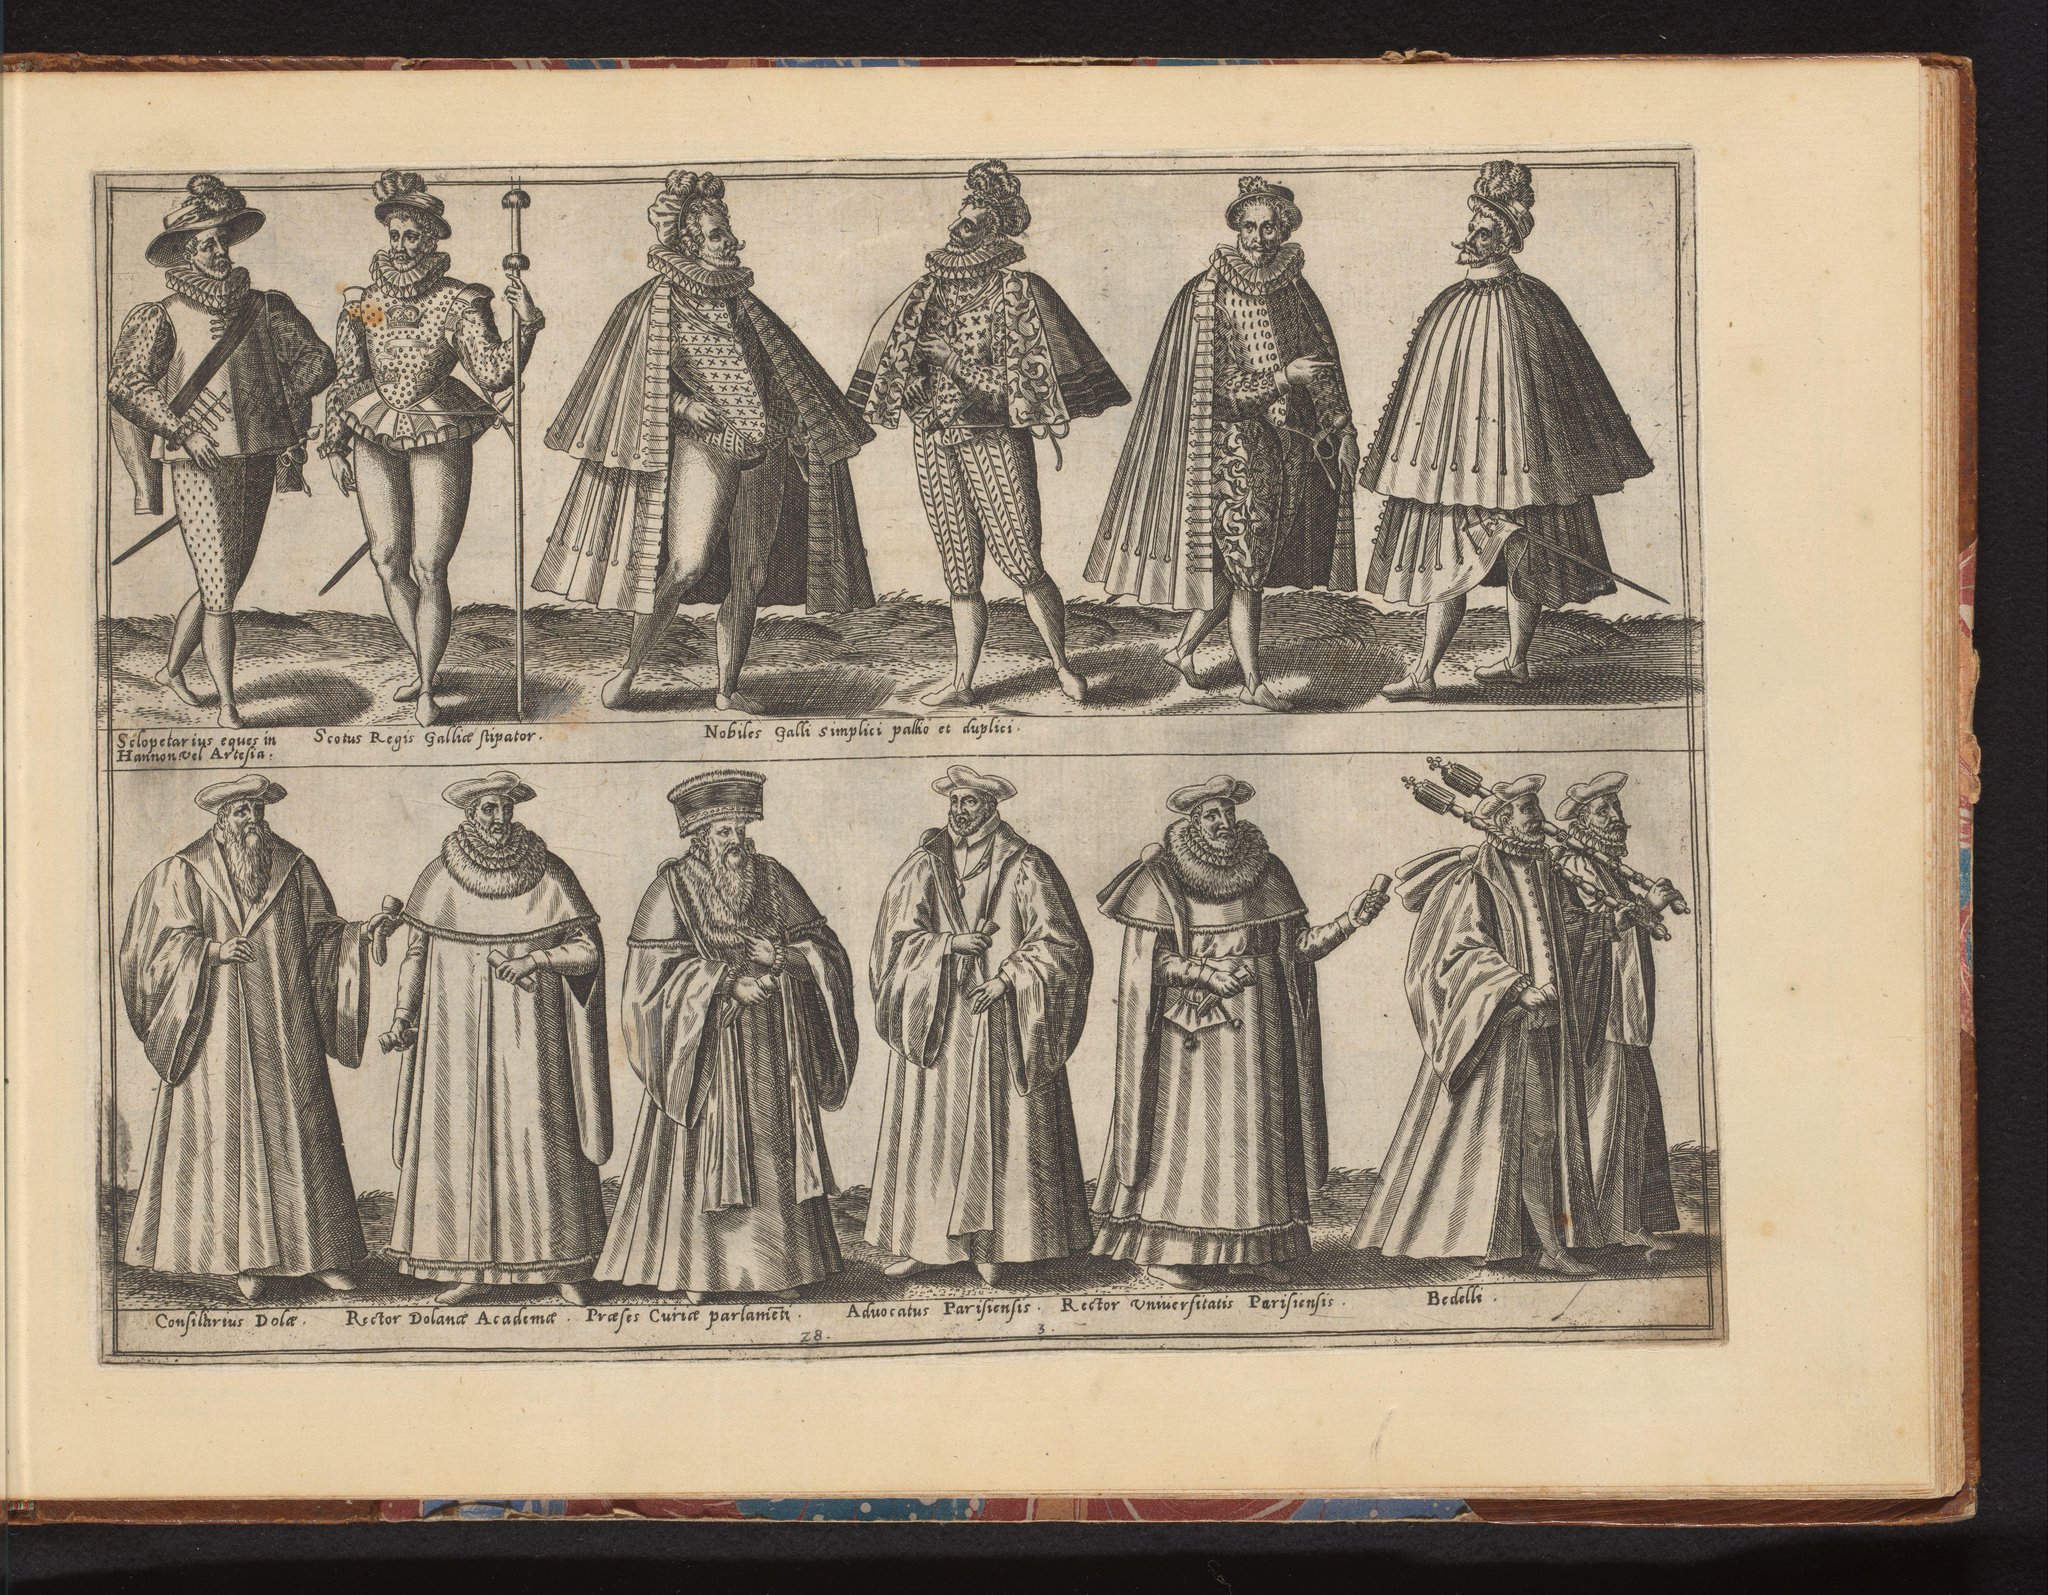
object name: album leaf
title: Dertien mannen uit verschillende standen, gekleed volgens de Franse mode van ca. 1580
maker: abraham de bruyn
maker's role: print maker, publisher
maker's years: 1540-1587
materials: paper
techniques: engraving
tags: europeans (with name) (+ costume), europeans (frenchmen) (+ men), bourgeoisie, middle class, citizens, burghers, clothes, costume (+ men's clothes), nobility and patriciate; chivalry, knighthood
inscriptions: number: ‘28’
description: Twee rijen boven elkaar. Prent uit het boek 'Omnium pene Europae, Asiae, Aphricae atque Americae gentium habitus...', 1581. De prent maakt deel uit van een album.